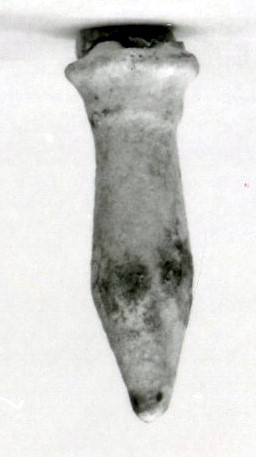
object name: pendant, lotus petal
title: Lotus Pendant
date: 664-332 BCE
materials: faience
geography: egypt